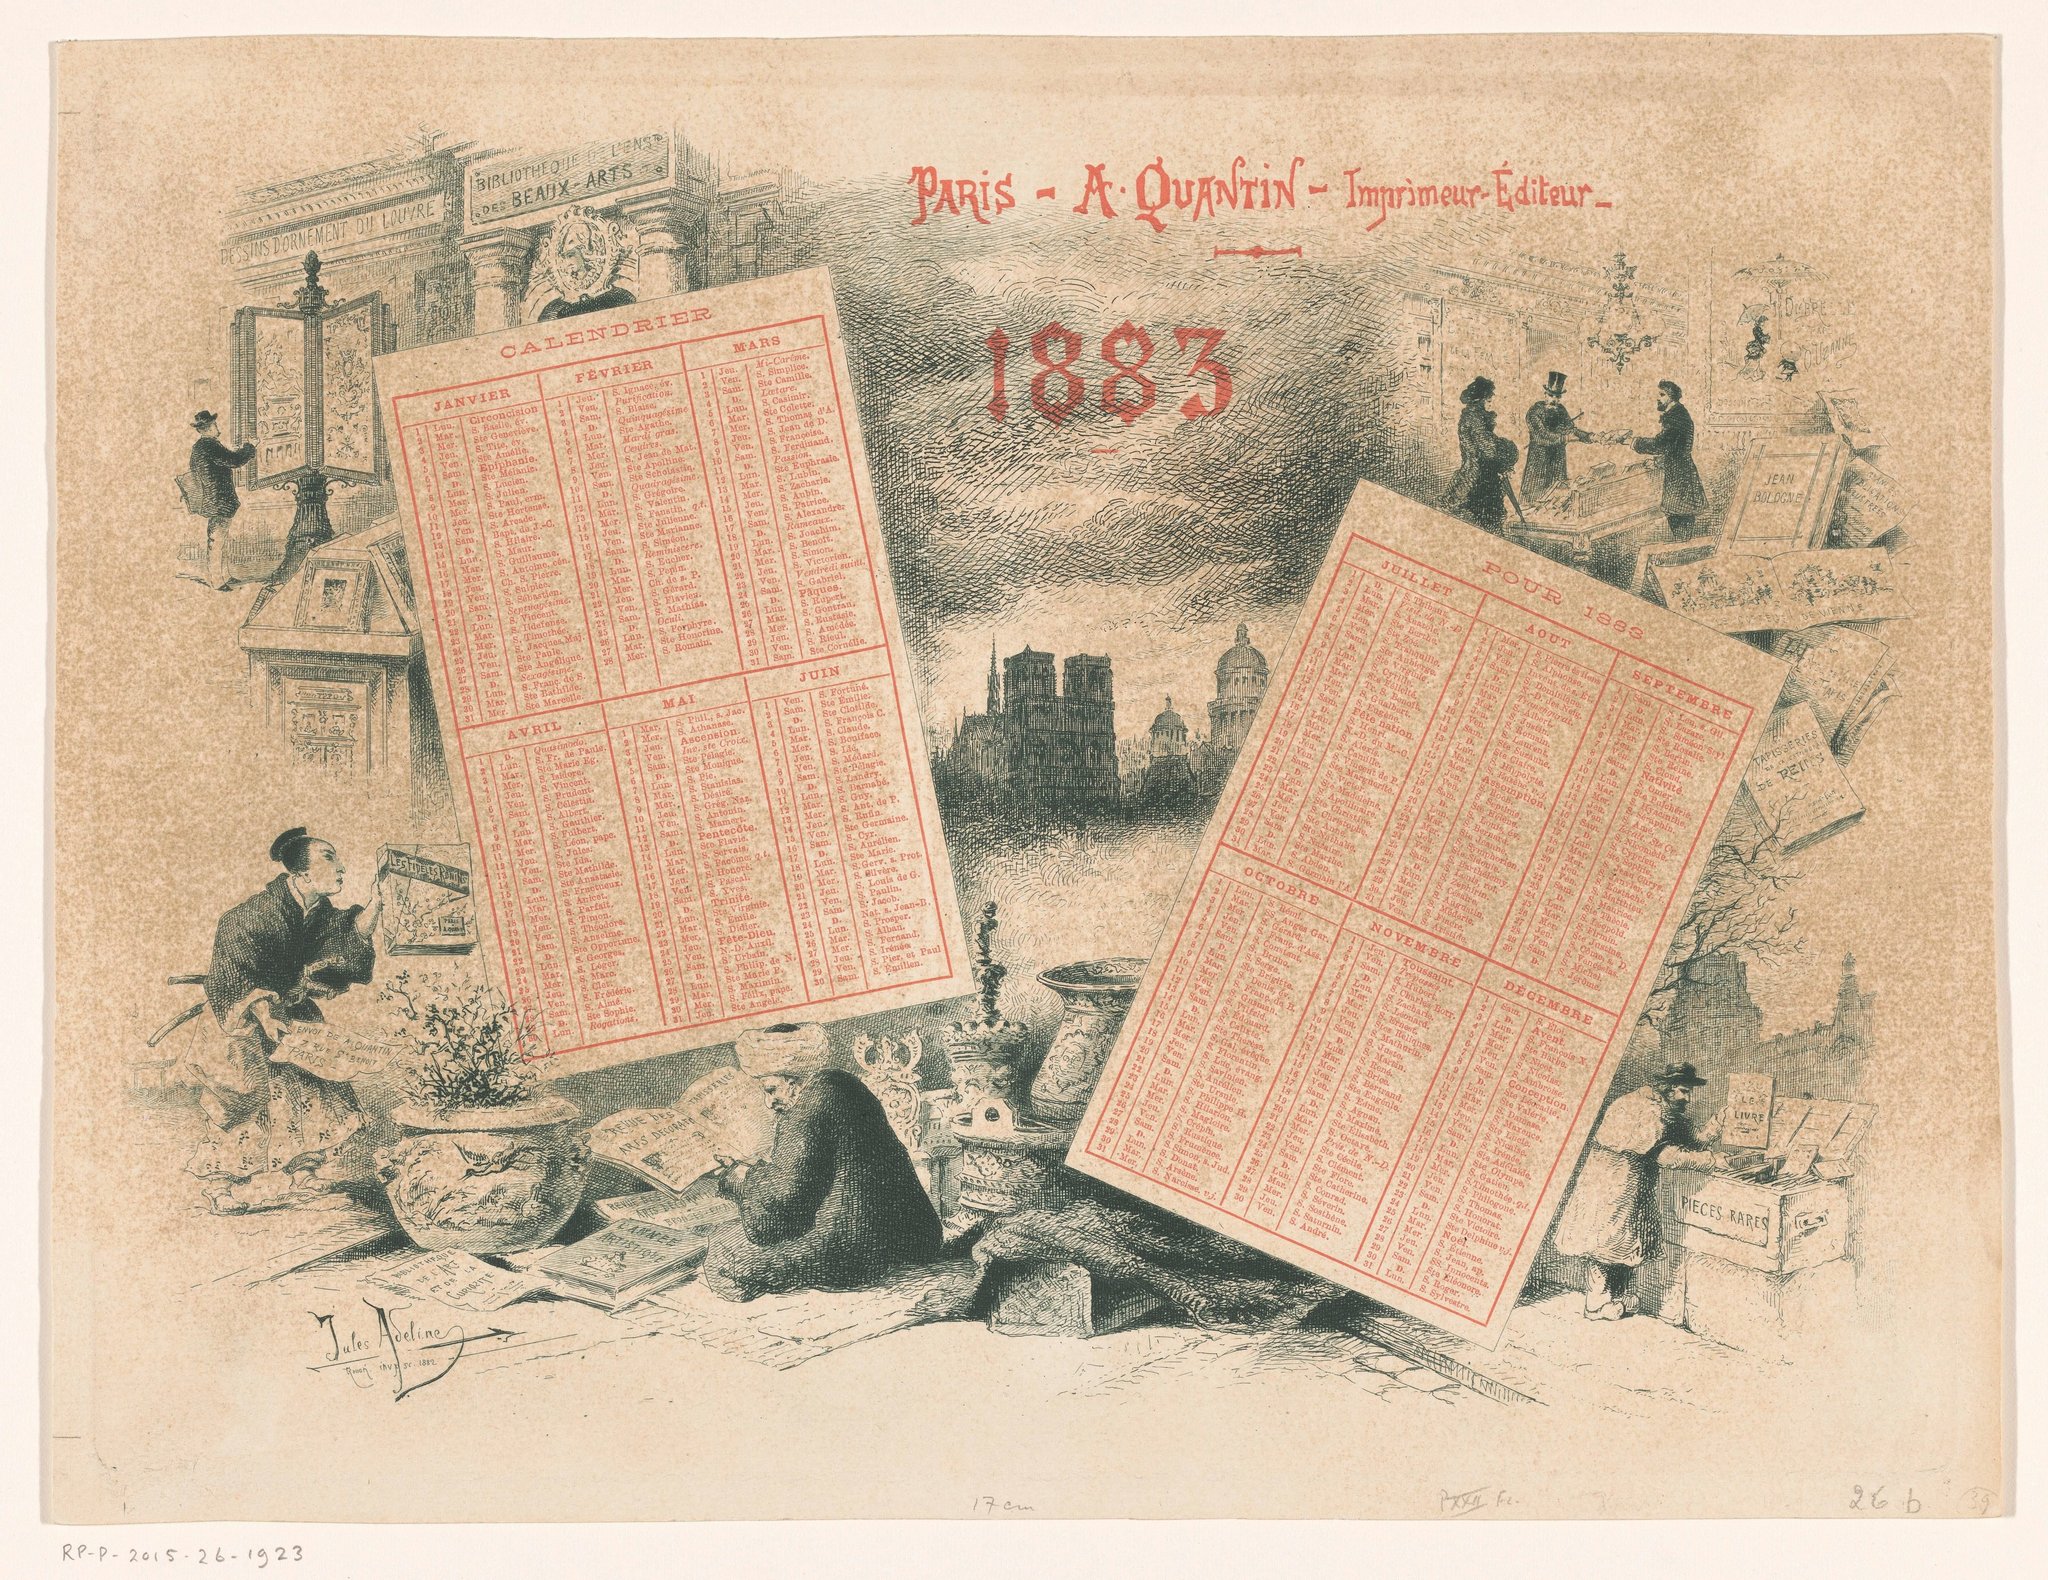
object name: print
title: Kalender van uitgeverij A. Quantin voor het jaar 1883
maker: louis jules adeline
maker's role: print maker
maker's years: 1845-1909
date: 1882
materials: paper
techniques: etching, letterpress printing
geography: rouen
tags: calendar, almanac, book-stall, kiosk, reading, head-gear: turban, book, japanese, book-shop, bookseller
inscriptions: collector's mark: Lugt 4779, collector's mark: Lugt 2228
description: Boven een man in een museum, een gezicht op de Notre-Dame en het interieur van een boekhandel. Onder een Japanse vrouw met een boek in haar handen, een lezende man met een tulband en een man voor een boekenkraam op een kade.